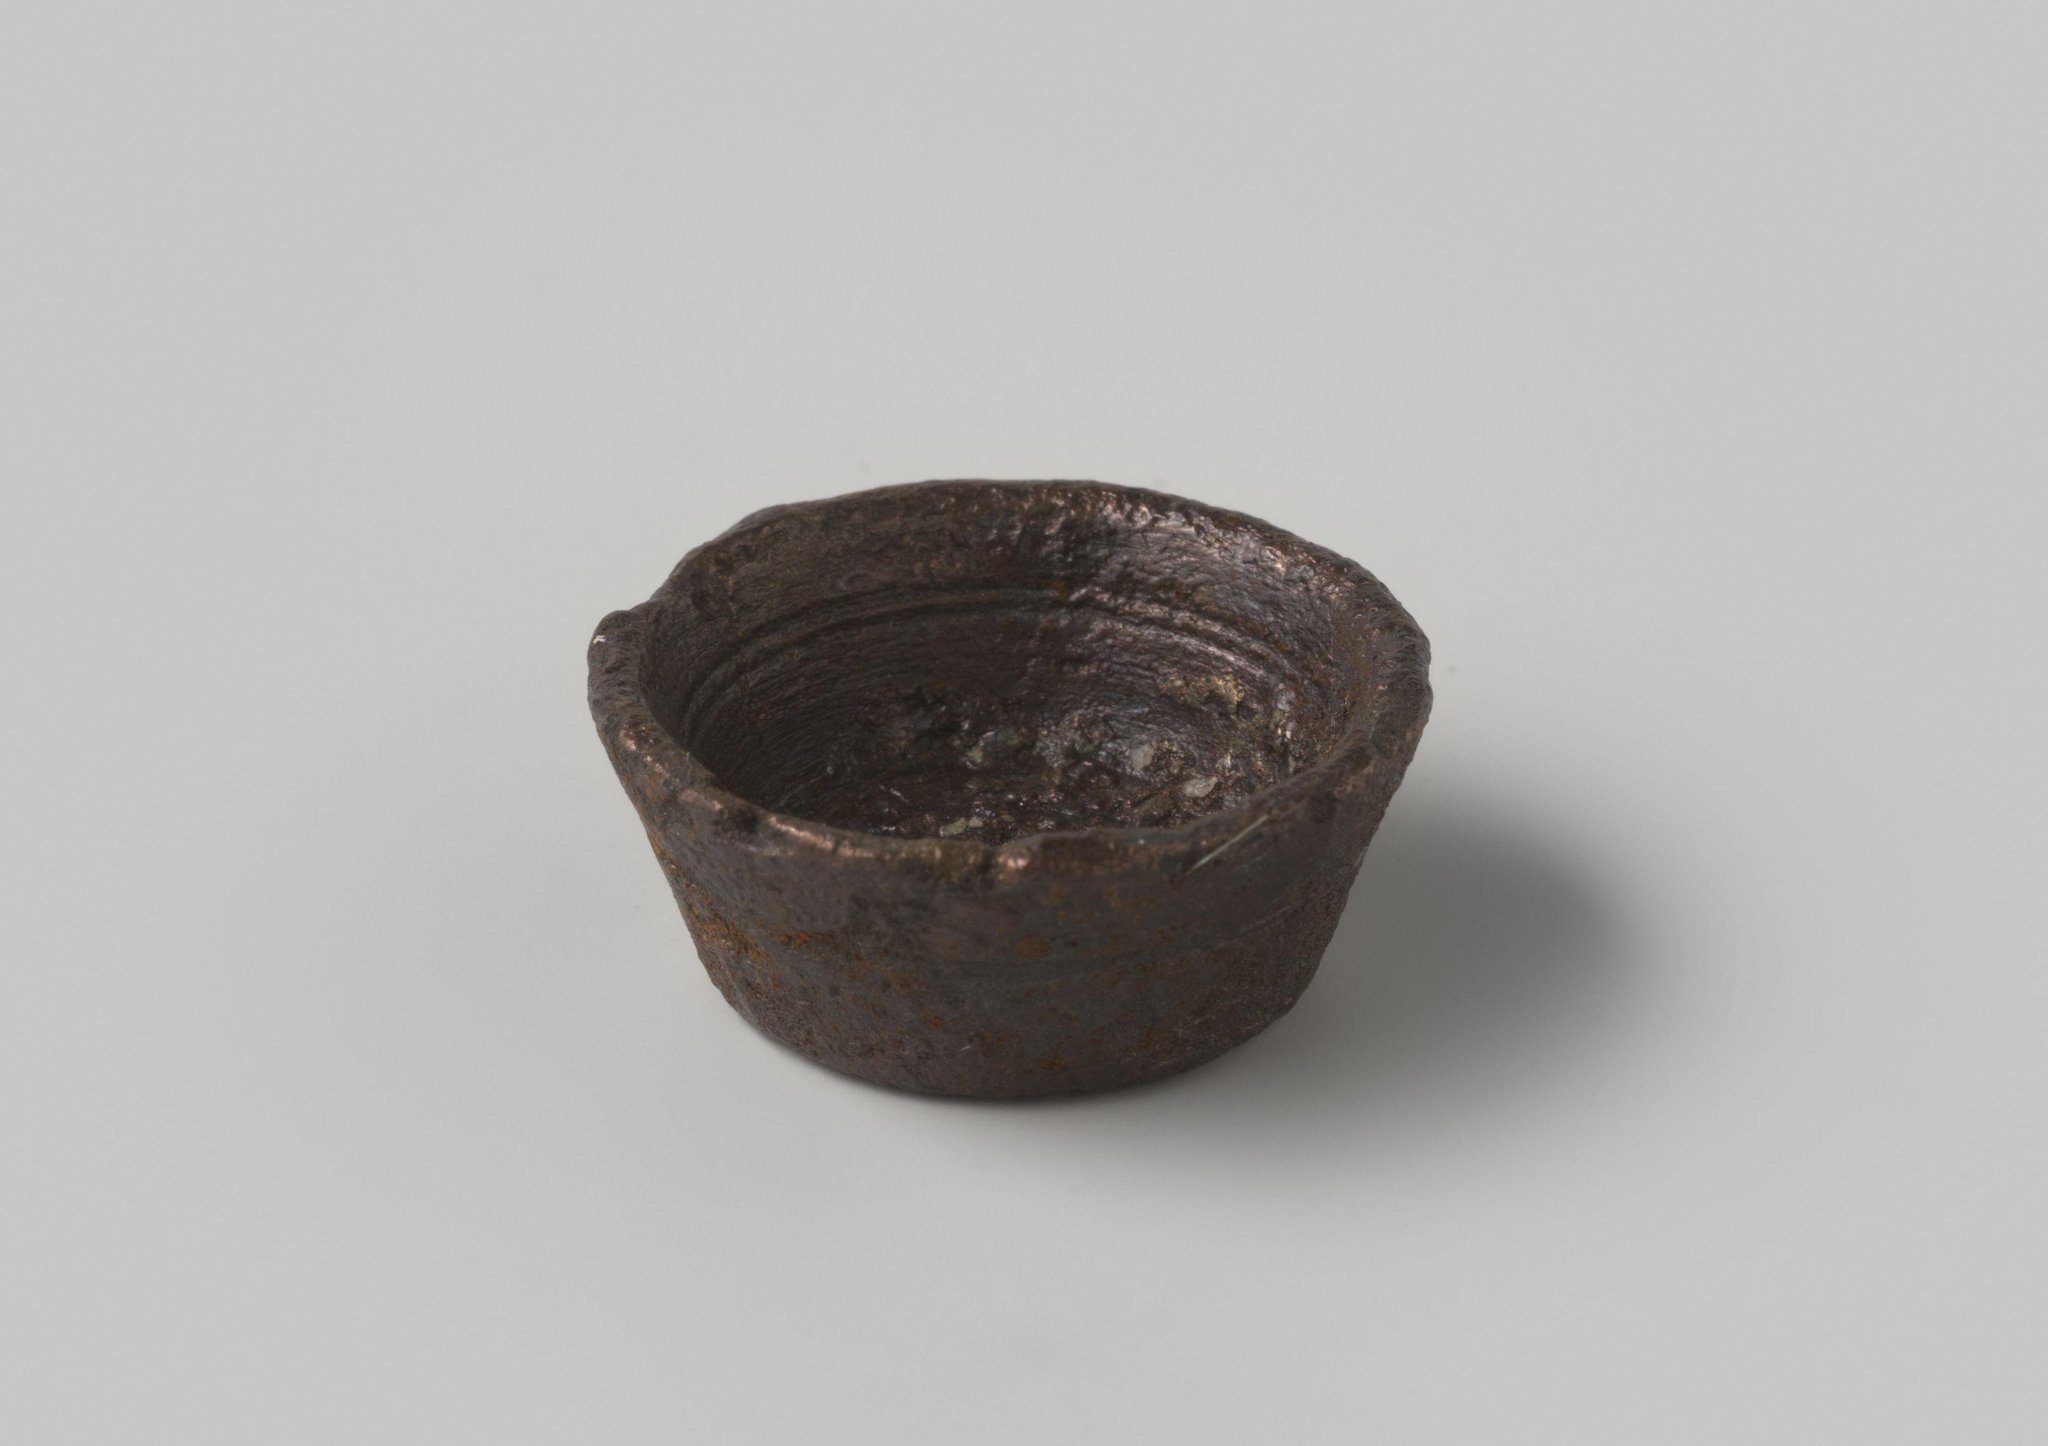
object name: weight scale component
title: Gewicht van sluitgewicht uit het wrak van de Oost-Indiëvaarder Hollandia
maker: Anonymous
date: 1700-1743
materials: copper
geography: netherlands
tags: verenigde oostindische compagnie, hollandia (schip), annet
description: Weight, cupweight, cup; id. NG 1980-27H2775, eroded, no marks legible.